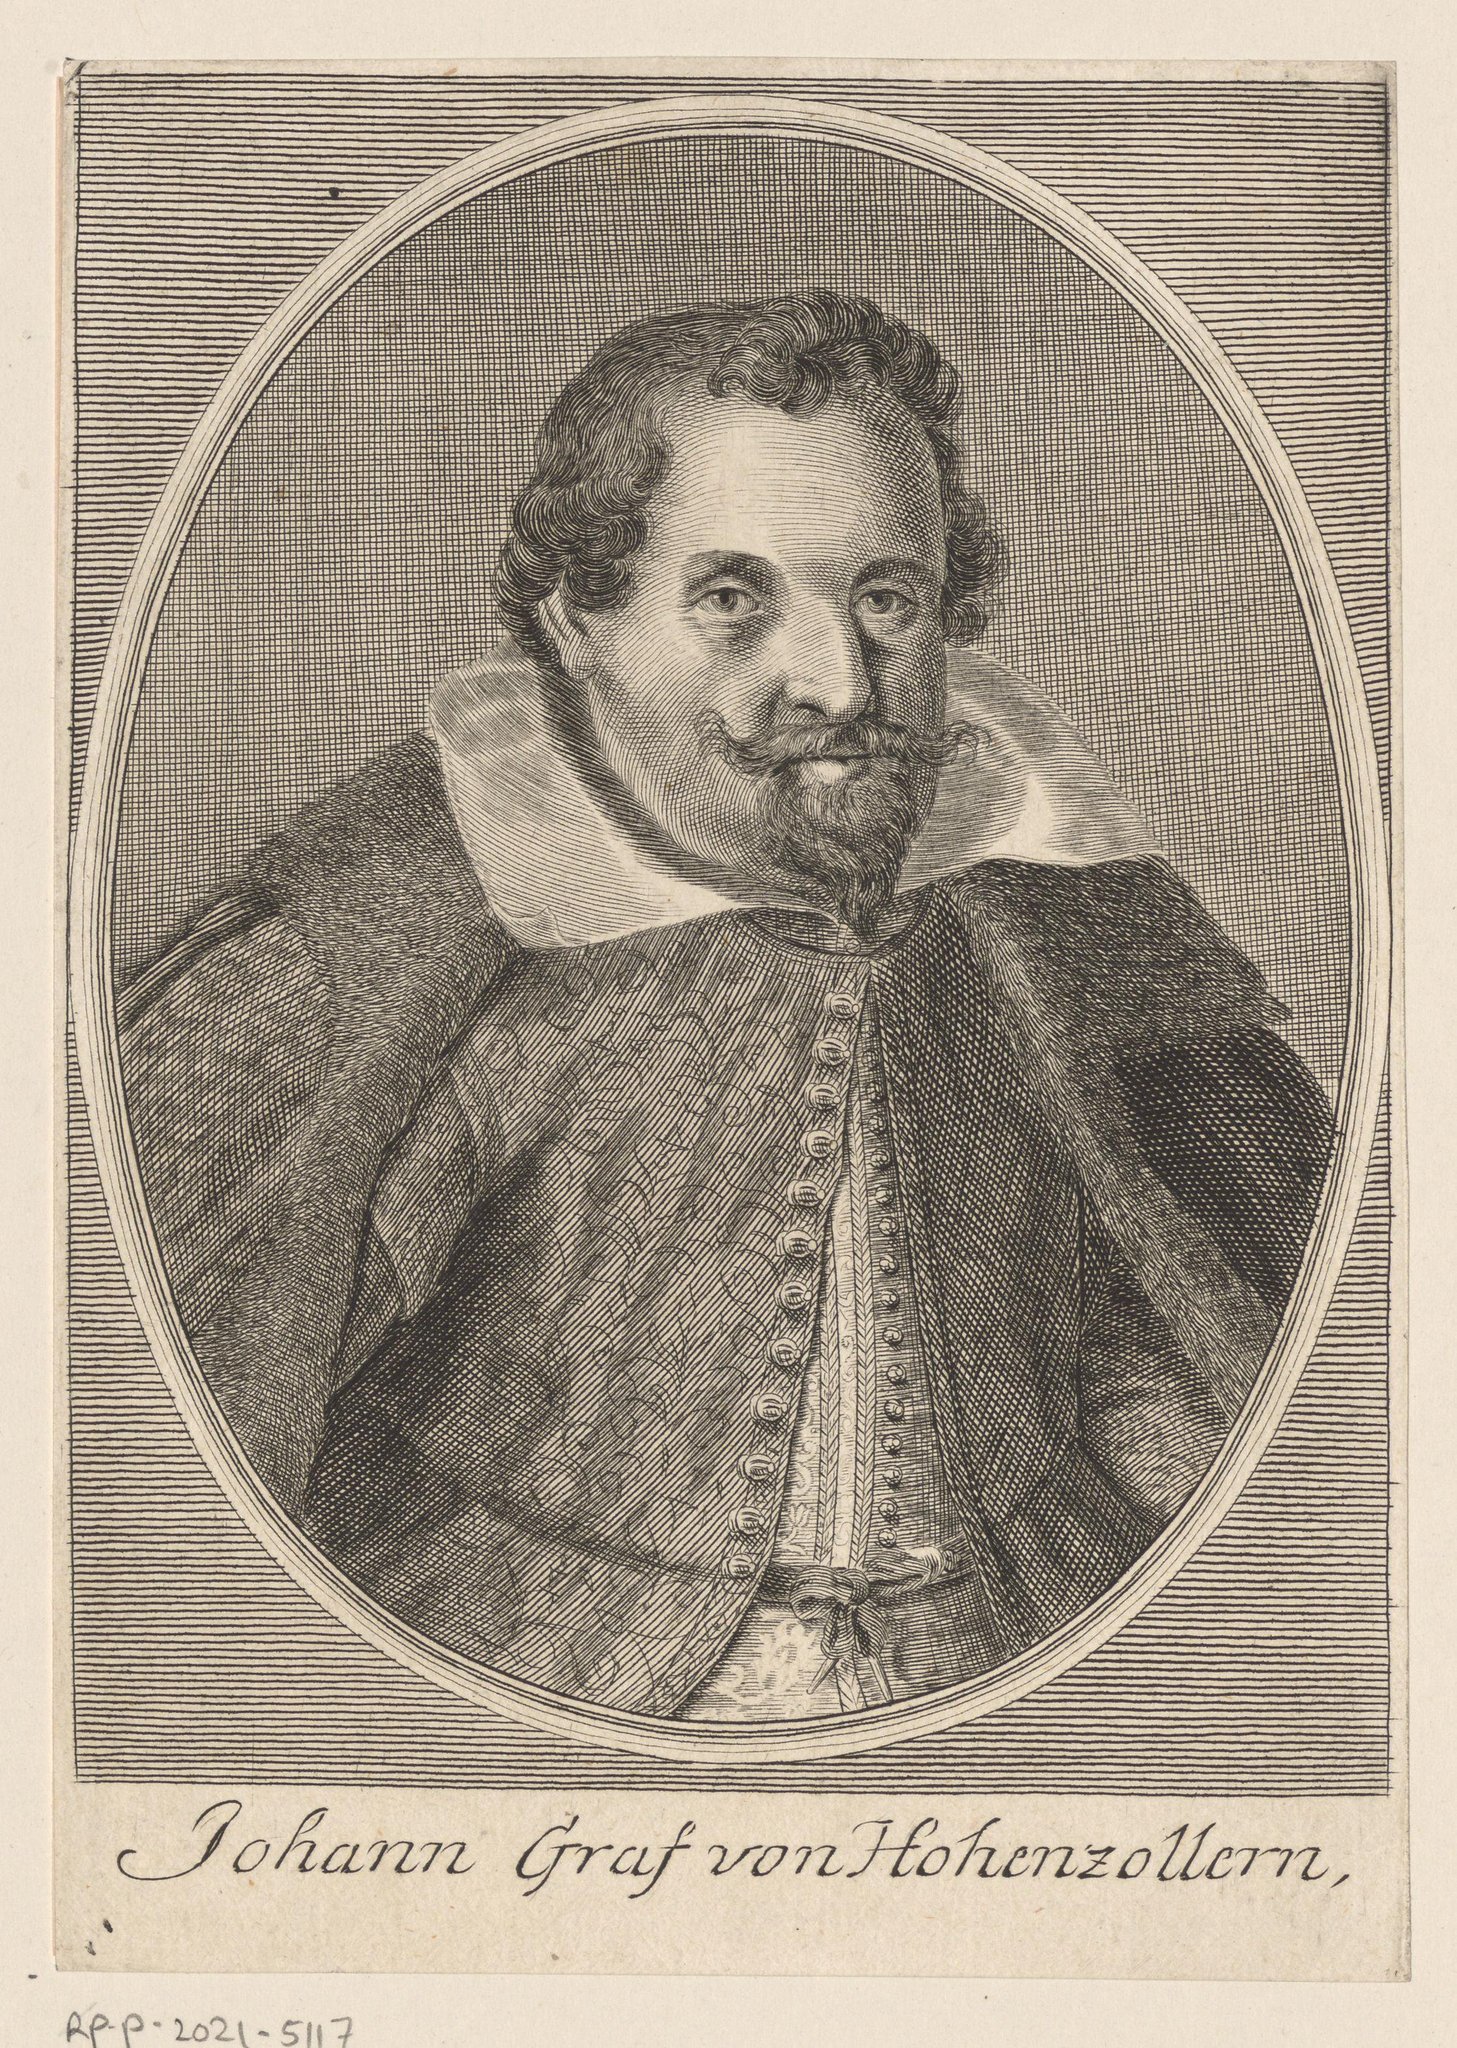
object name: print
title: Portret van Johann von Hohenzollern-Sigmaringen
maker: Anonymous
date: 1722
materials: paper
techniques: engraving, etching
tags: adult man, historical persons, beard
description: Prent met omlijsting gebruikt in: Khevenhüller, Franz Christoph. Conterfet Kupfferstich (...). Leipzig: Moritz Georg Weidmann, 1722, dl. 2.